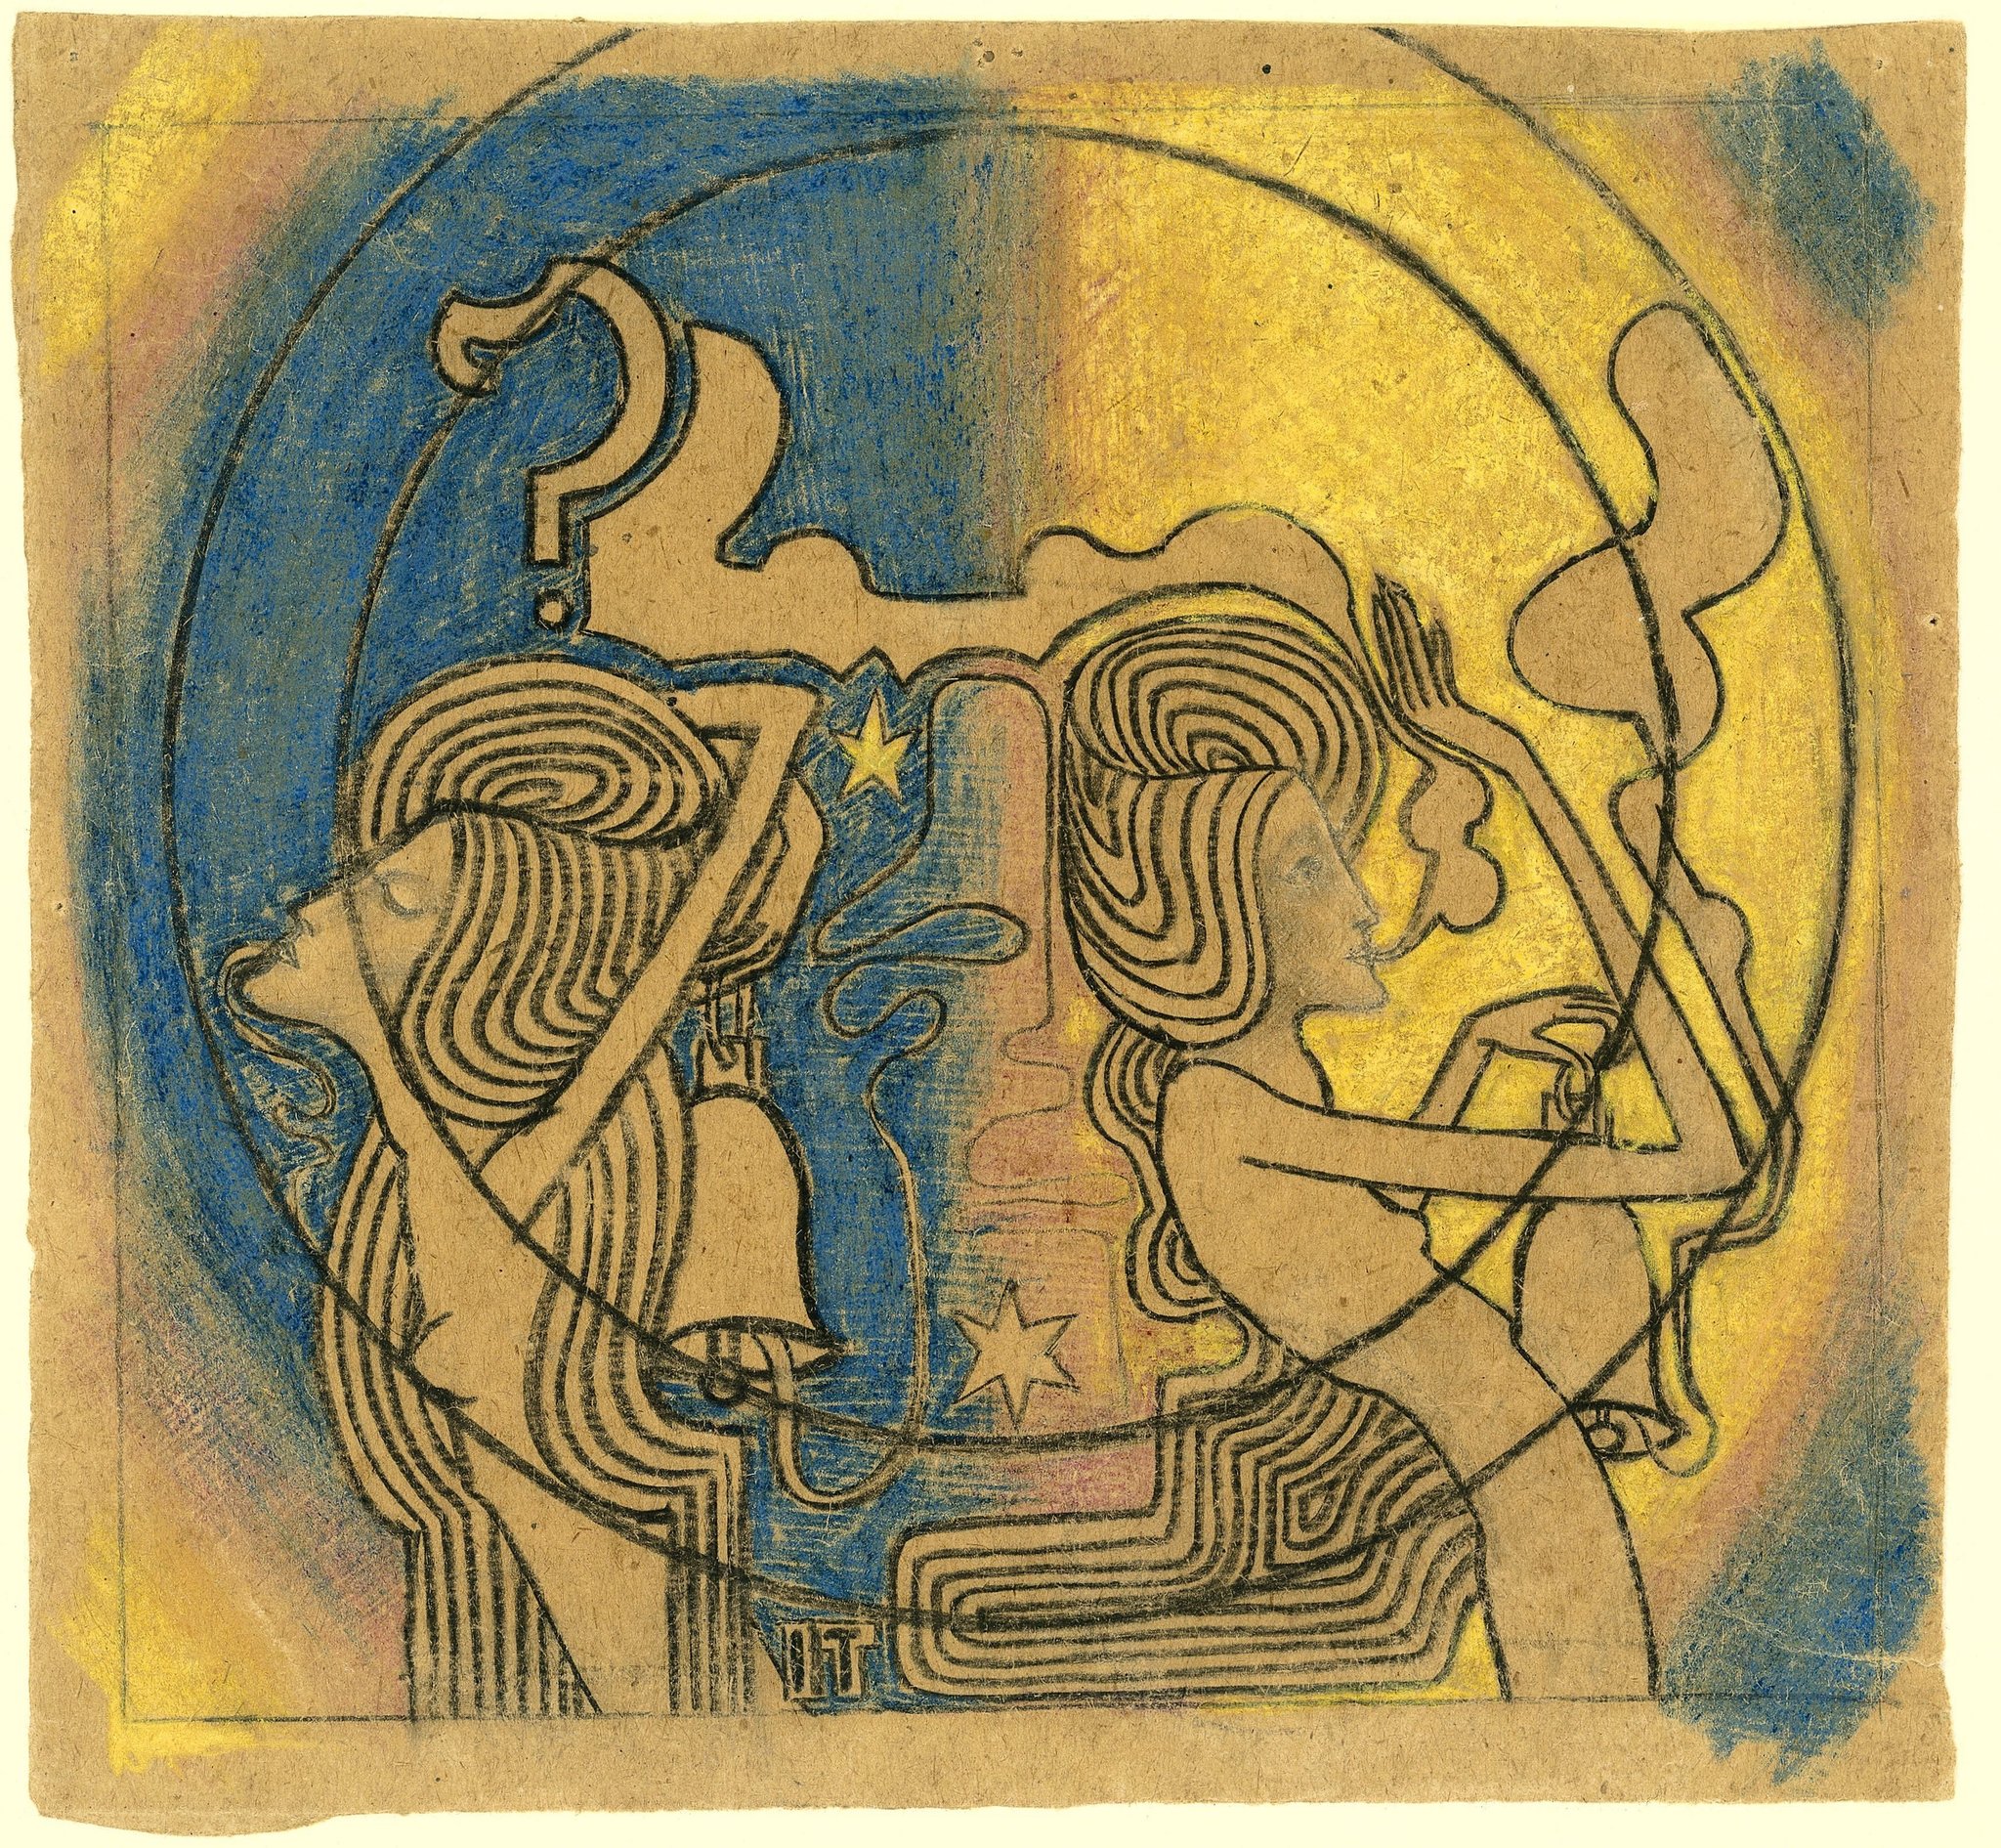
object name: drawing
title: Twee gestileerde vrouwelijke figuren met klok in de hand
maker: jan toorop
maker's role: draughtsman, painter, print maker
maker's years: 1858-1928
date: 1868-1913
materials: chalk, paper, pencil